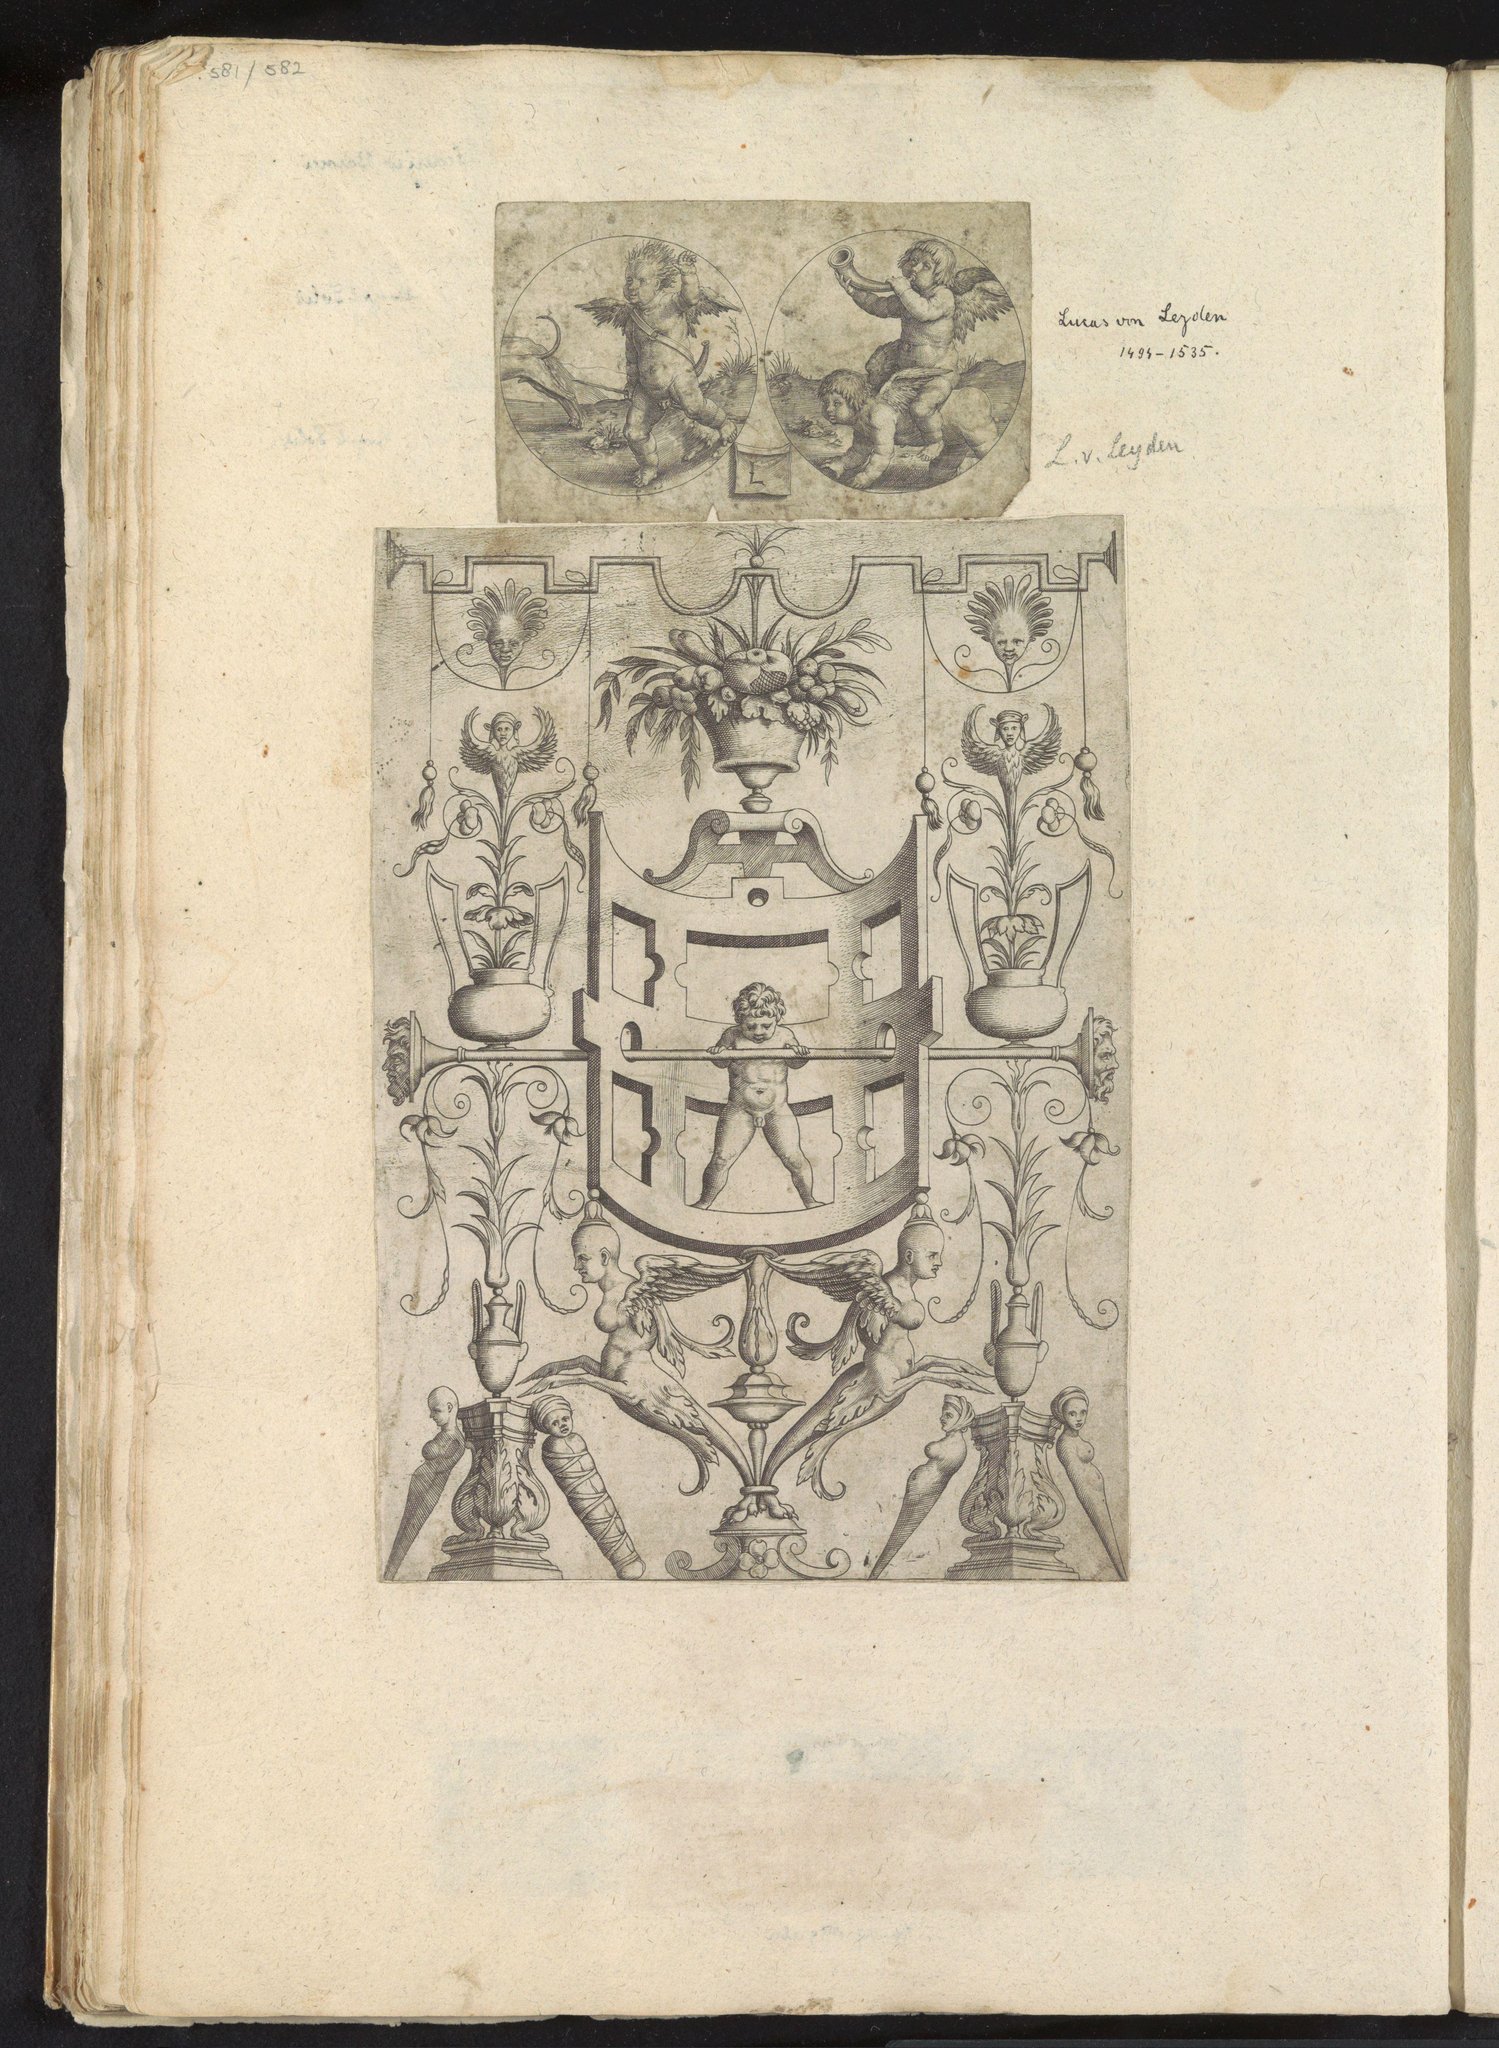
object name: ornament print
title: Albumblad met twee prenten met putti in cirkels en ornament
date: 1500-1599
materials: paper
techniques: engraving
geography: netherlands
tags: ornaments ~ art, cupids: 'amores', 'amoretti', 'putti'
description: Albumblad met twee uitgeknipte prenten: spelende putti in cirkels en een ornamentprent.